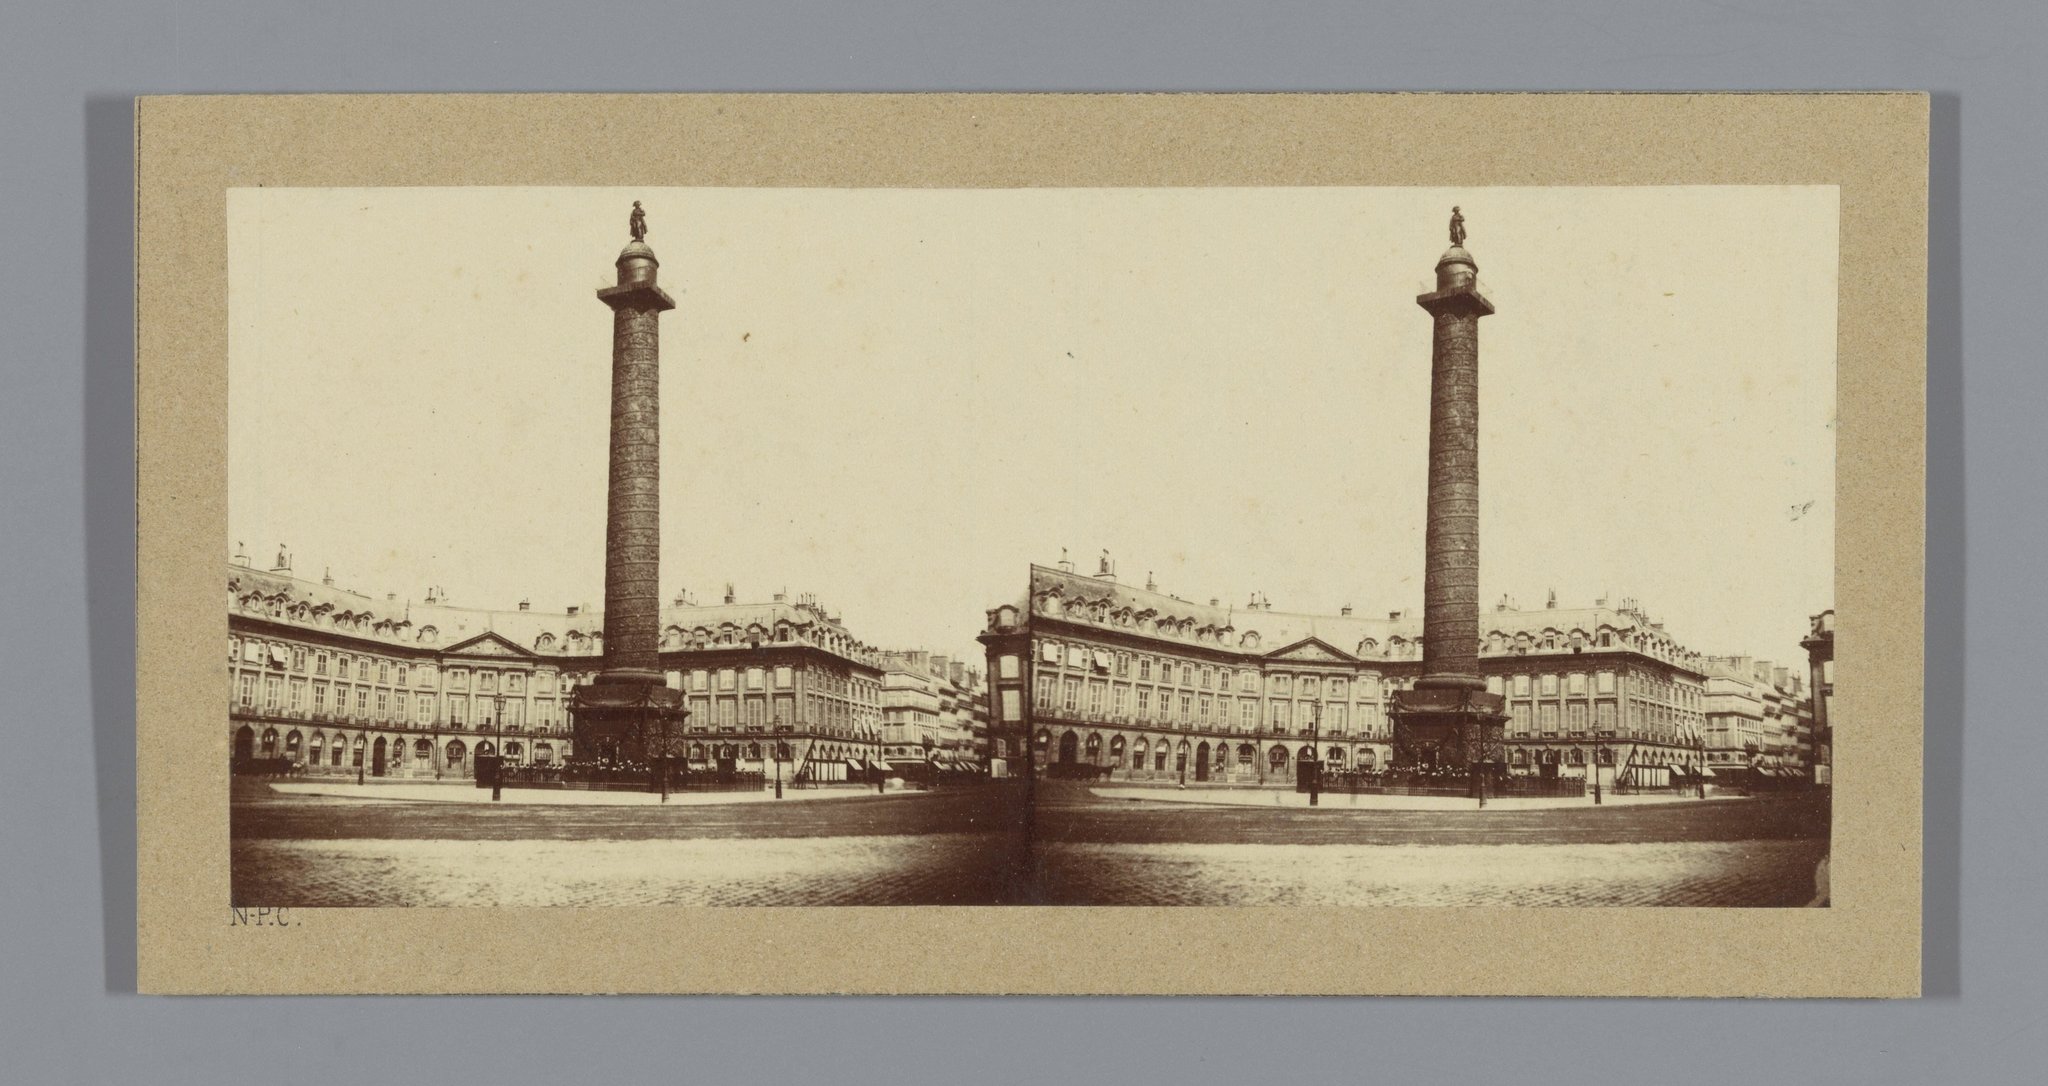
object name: stereograph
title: Colonne Vendôme te Parijs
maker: noël paul chapus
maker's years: 1832-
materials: cardboard, photographic support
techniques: albumen print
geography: place vendôme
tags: square, place, circus, etc., triumphal column with helical friezes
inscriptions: inscription: ‘Colonne Vendôme Paris’, name: ‘Banselin opticien Ft. R. Bonaparte .5’